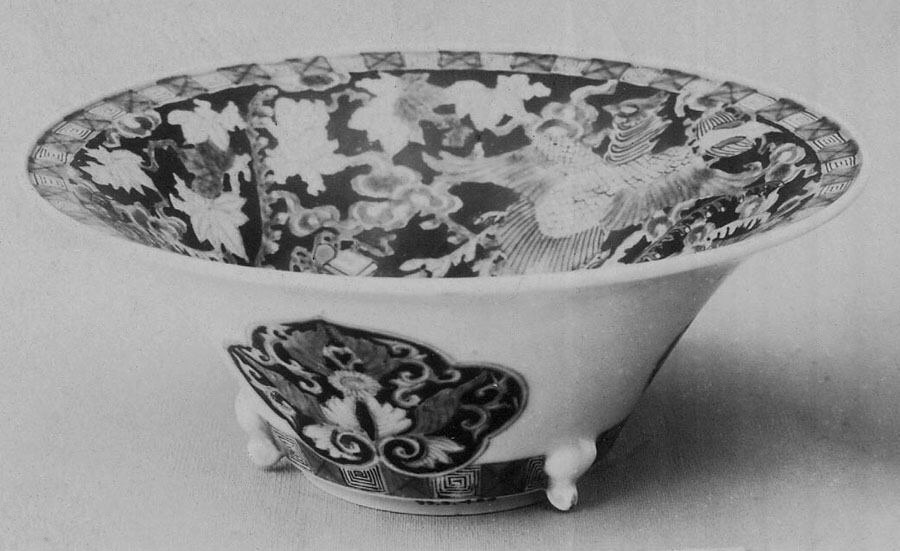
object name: bowl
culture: japanese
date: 1780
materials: enamel, glaze, porcelain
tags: birds,flowers